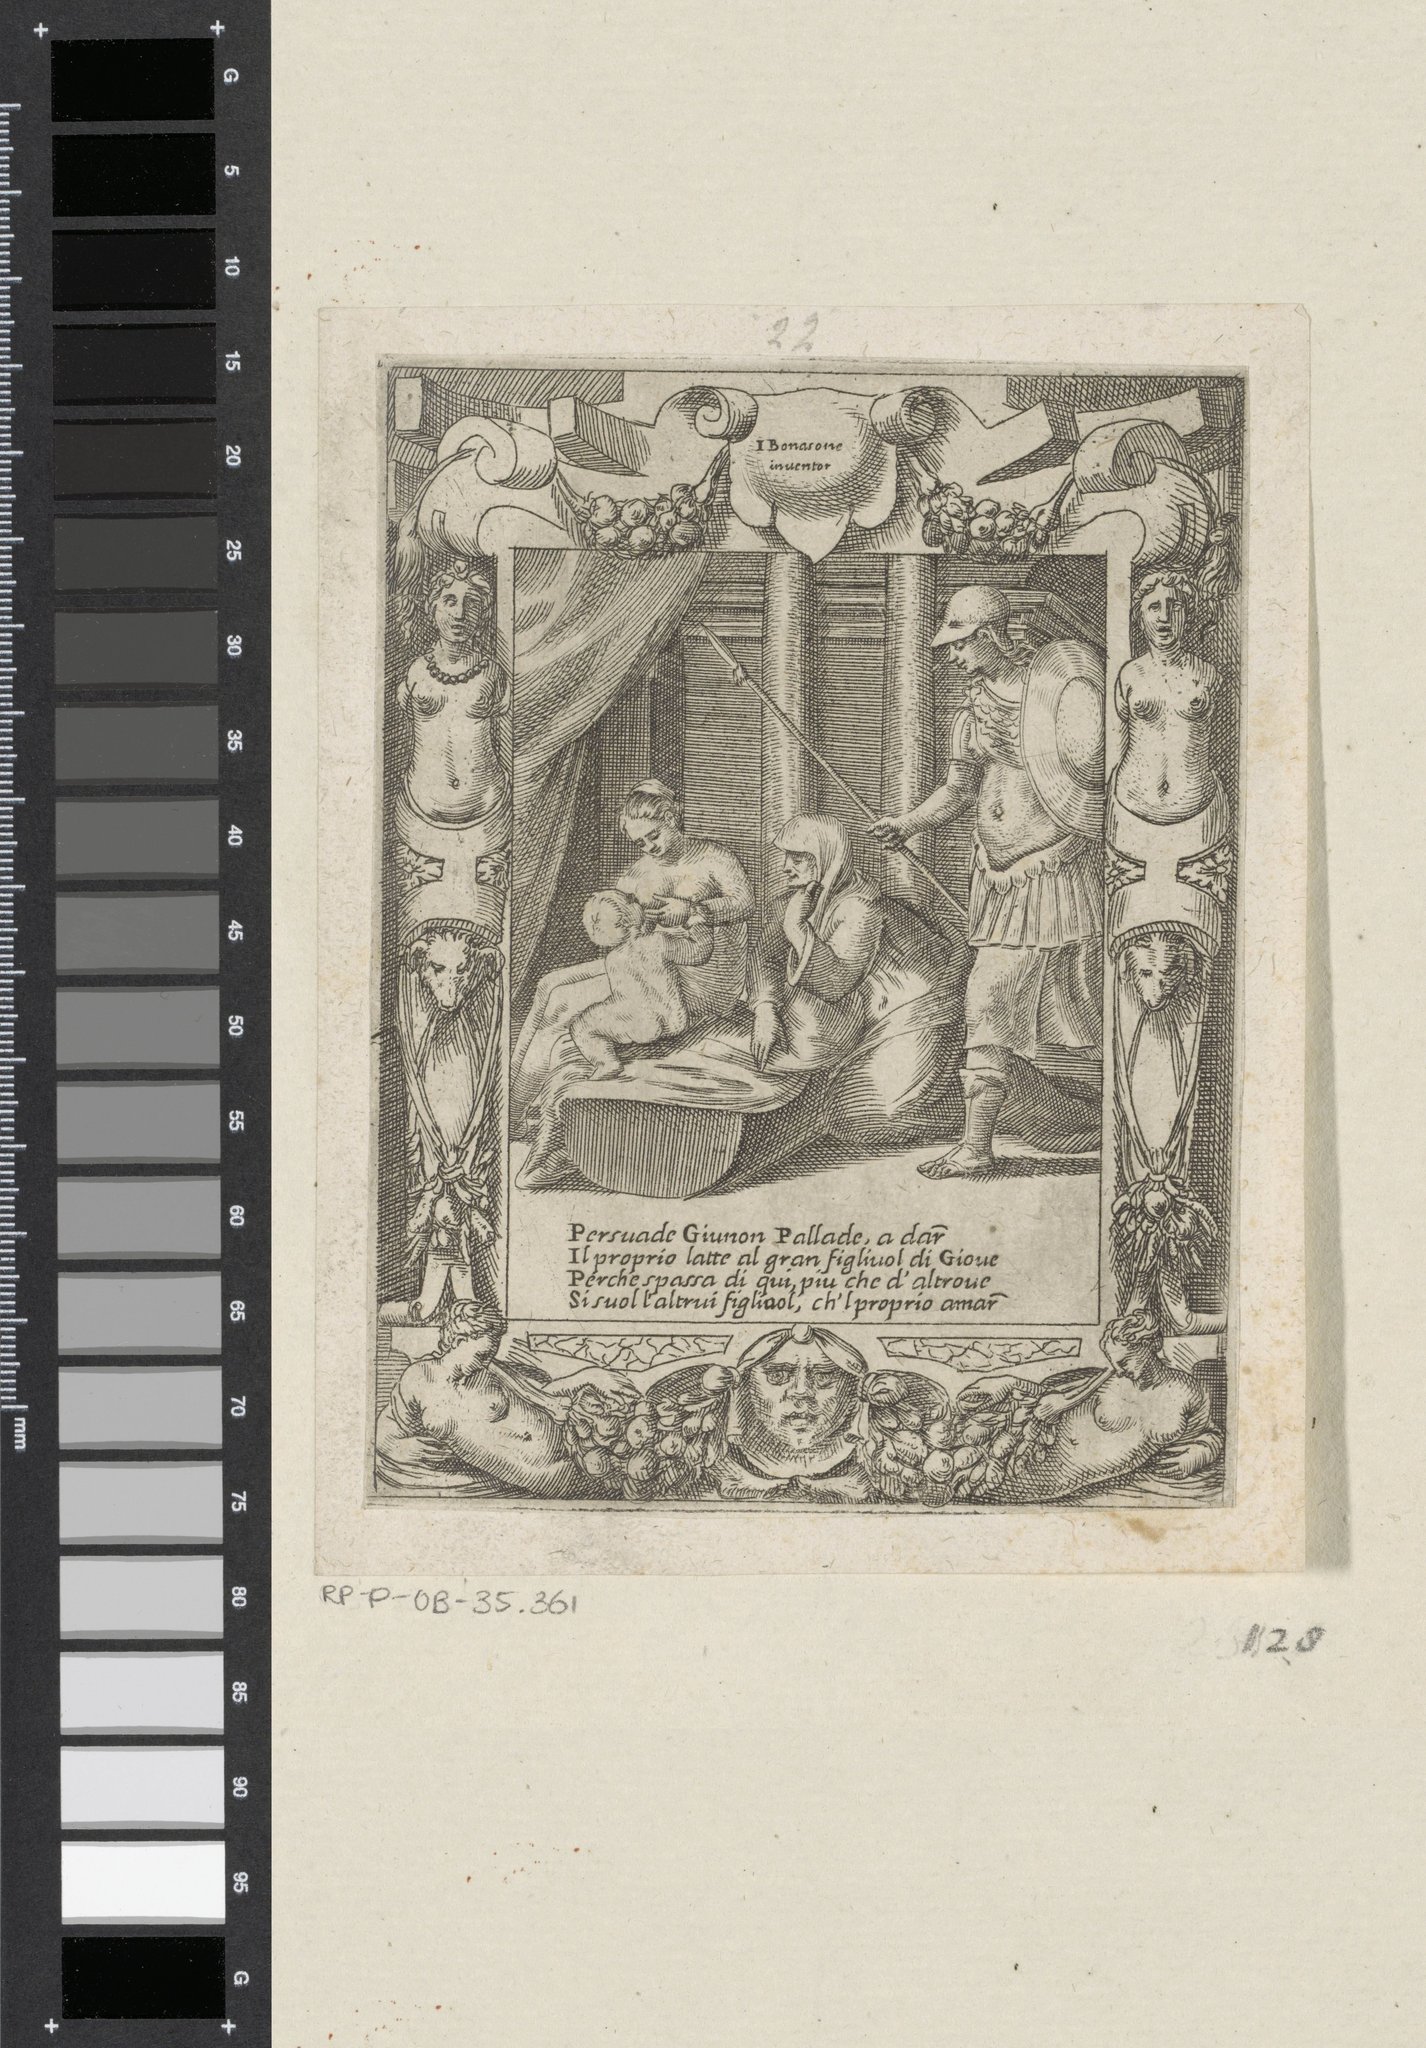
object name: print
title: Amori sdegni et gielosie di Giunone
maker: giulio bonasone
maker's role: painter, print maker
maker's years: 1510-1576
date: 1501-1580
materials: paper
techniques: engraving, etching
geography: italy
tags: (story of) juno (hera), hercules is found by juno and minerva; the latter puts him on juno's breast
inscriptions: collector's mark: Lugt 240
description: Juno zoogt de jonge Hercules. Rechts staat Minerva. Onder een vierregelig vers in het Italiaans. De voorstelling is gevat in een sierlijst met putti en sfinxen.